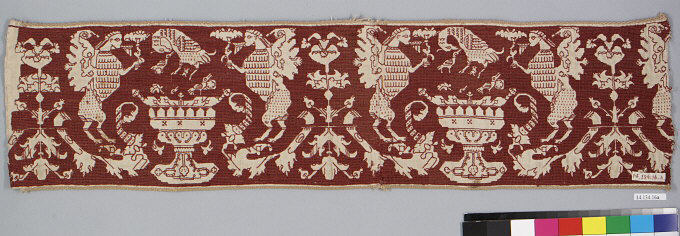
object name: border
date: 1601-1700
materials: linen, silk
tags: mythical creatures